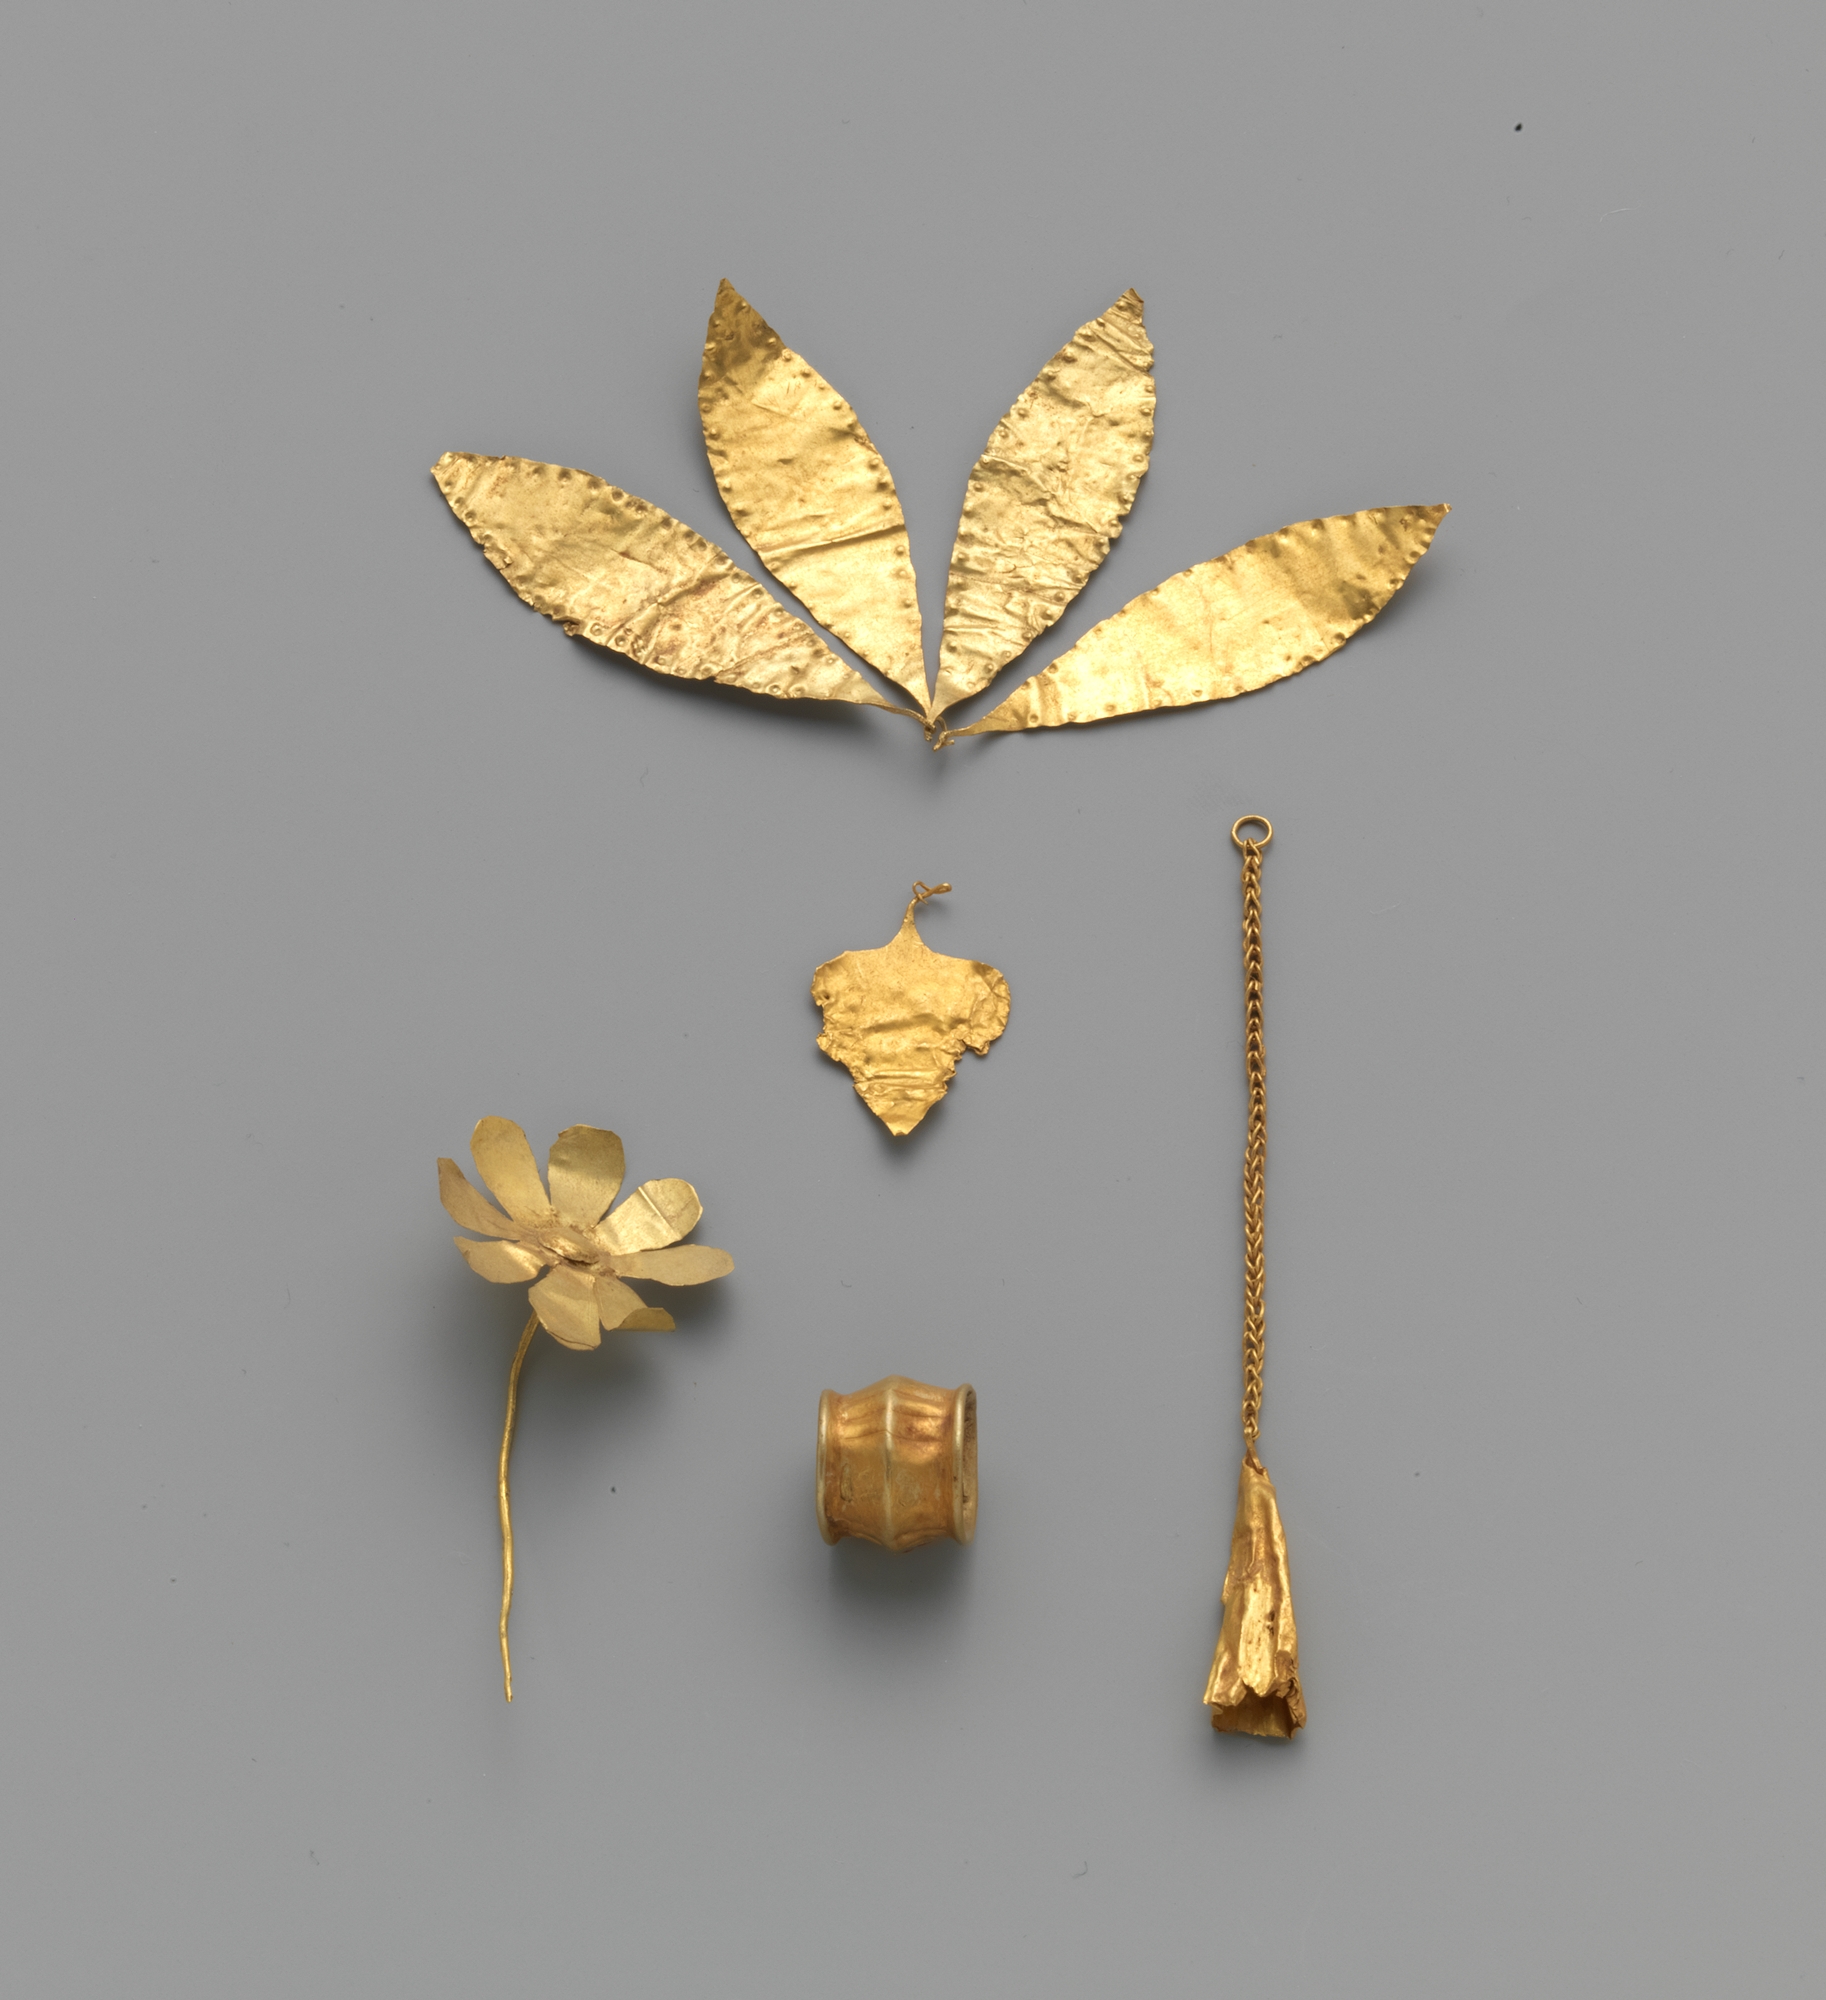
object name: pendant in the form of a leaf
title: Gold leaf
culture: minoan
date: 2300-2100 BCE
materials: gold